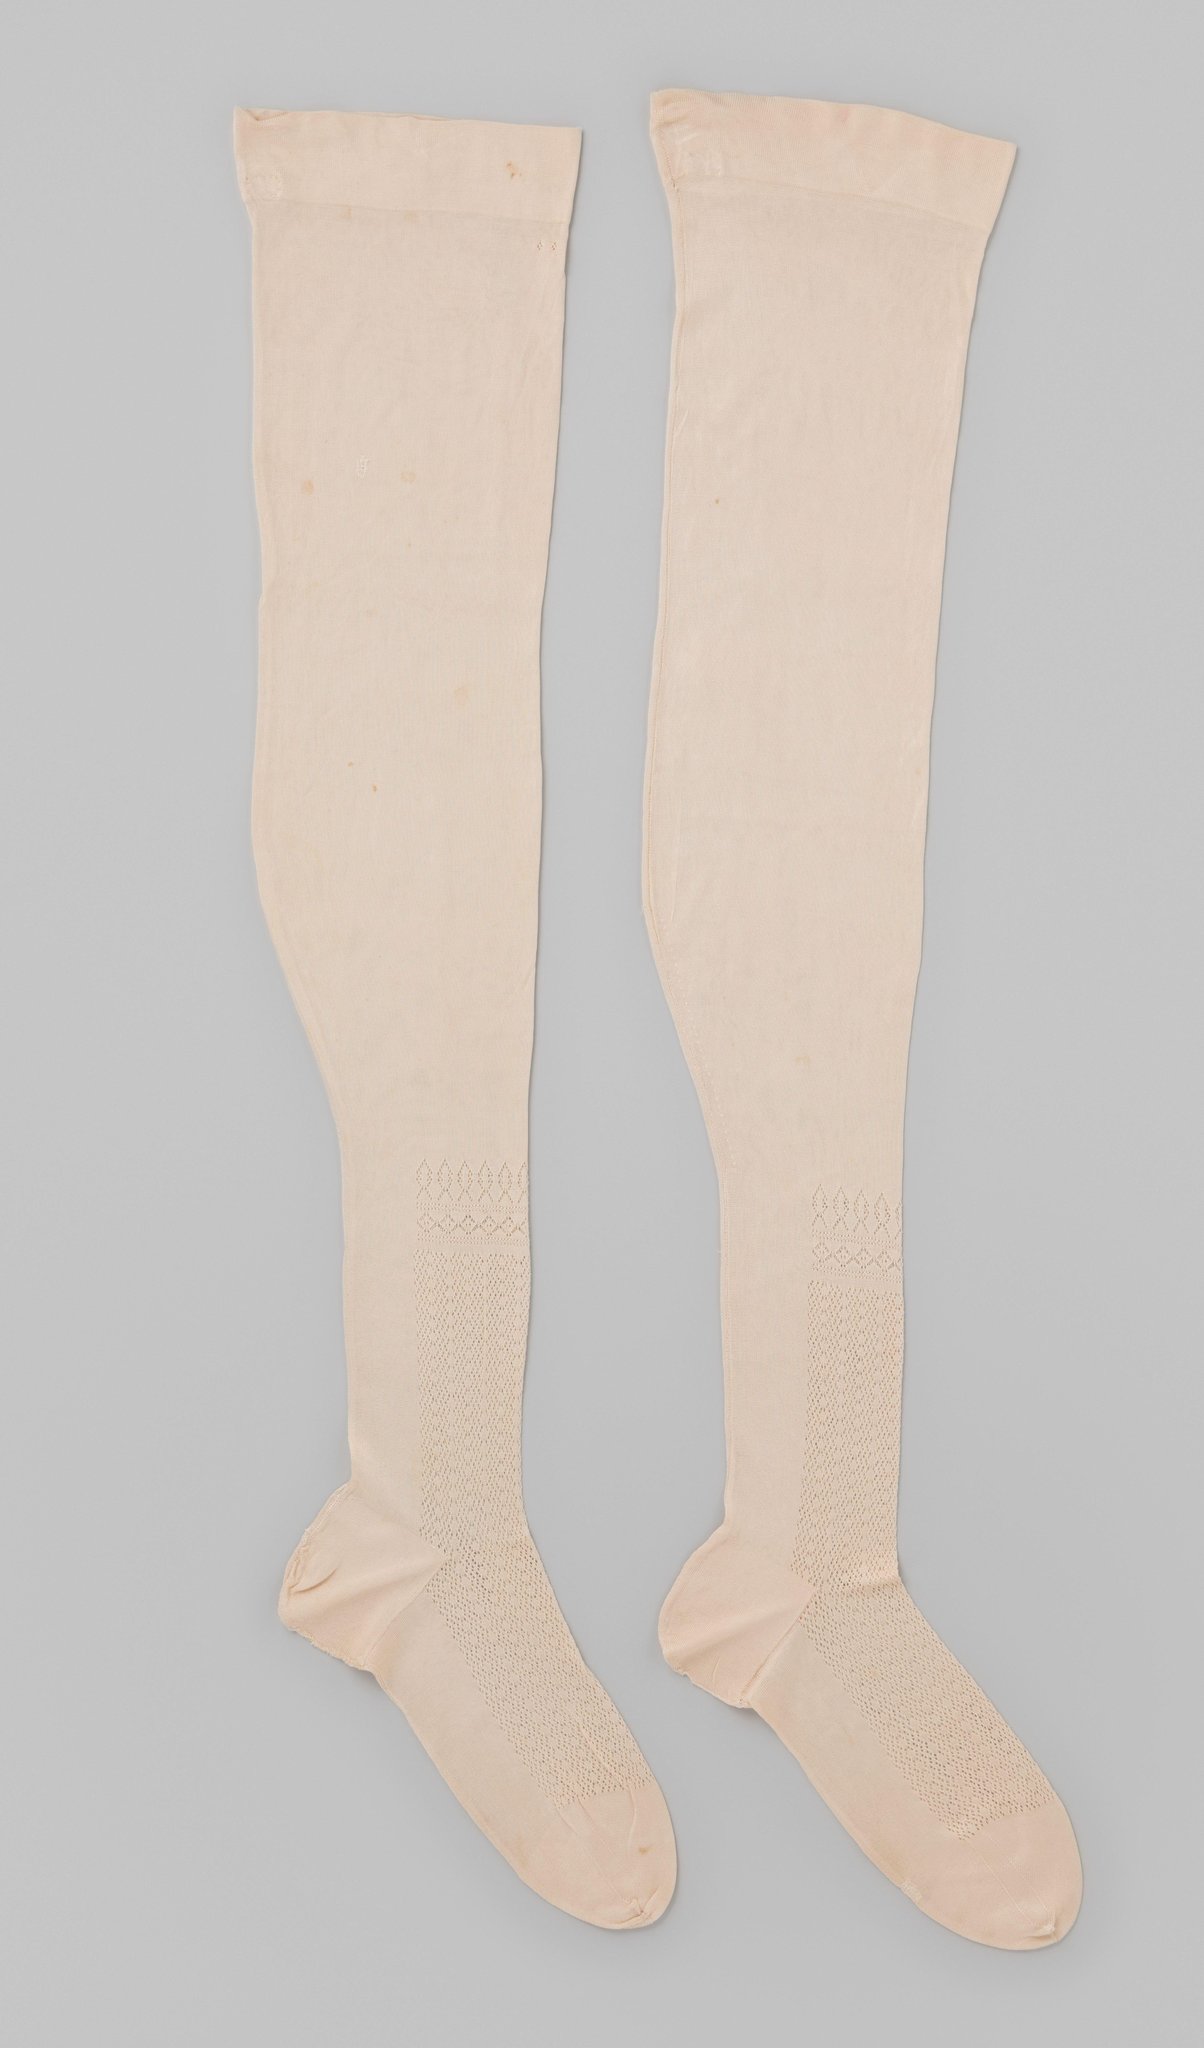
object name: stocking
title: Kous van crème zijde met opengewerkte klink van "kulier-breisel" op gesloten fond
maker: Anonymous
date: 1900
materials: silk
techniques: knitting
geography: berlin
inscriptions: laundry mark: ‘'W.B.'’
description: Kous van crème zijde met opengewerkt voorstuk van "kulier-breisel" op gesloten fond, met noppen, zigzagjes, dwarsstrepen met ruitjes en zeshoeken op pootjes. Naad middenachter. Wasmerk: W.B. (van den Wall Bake).